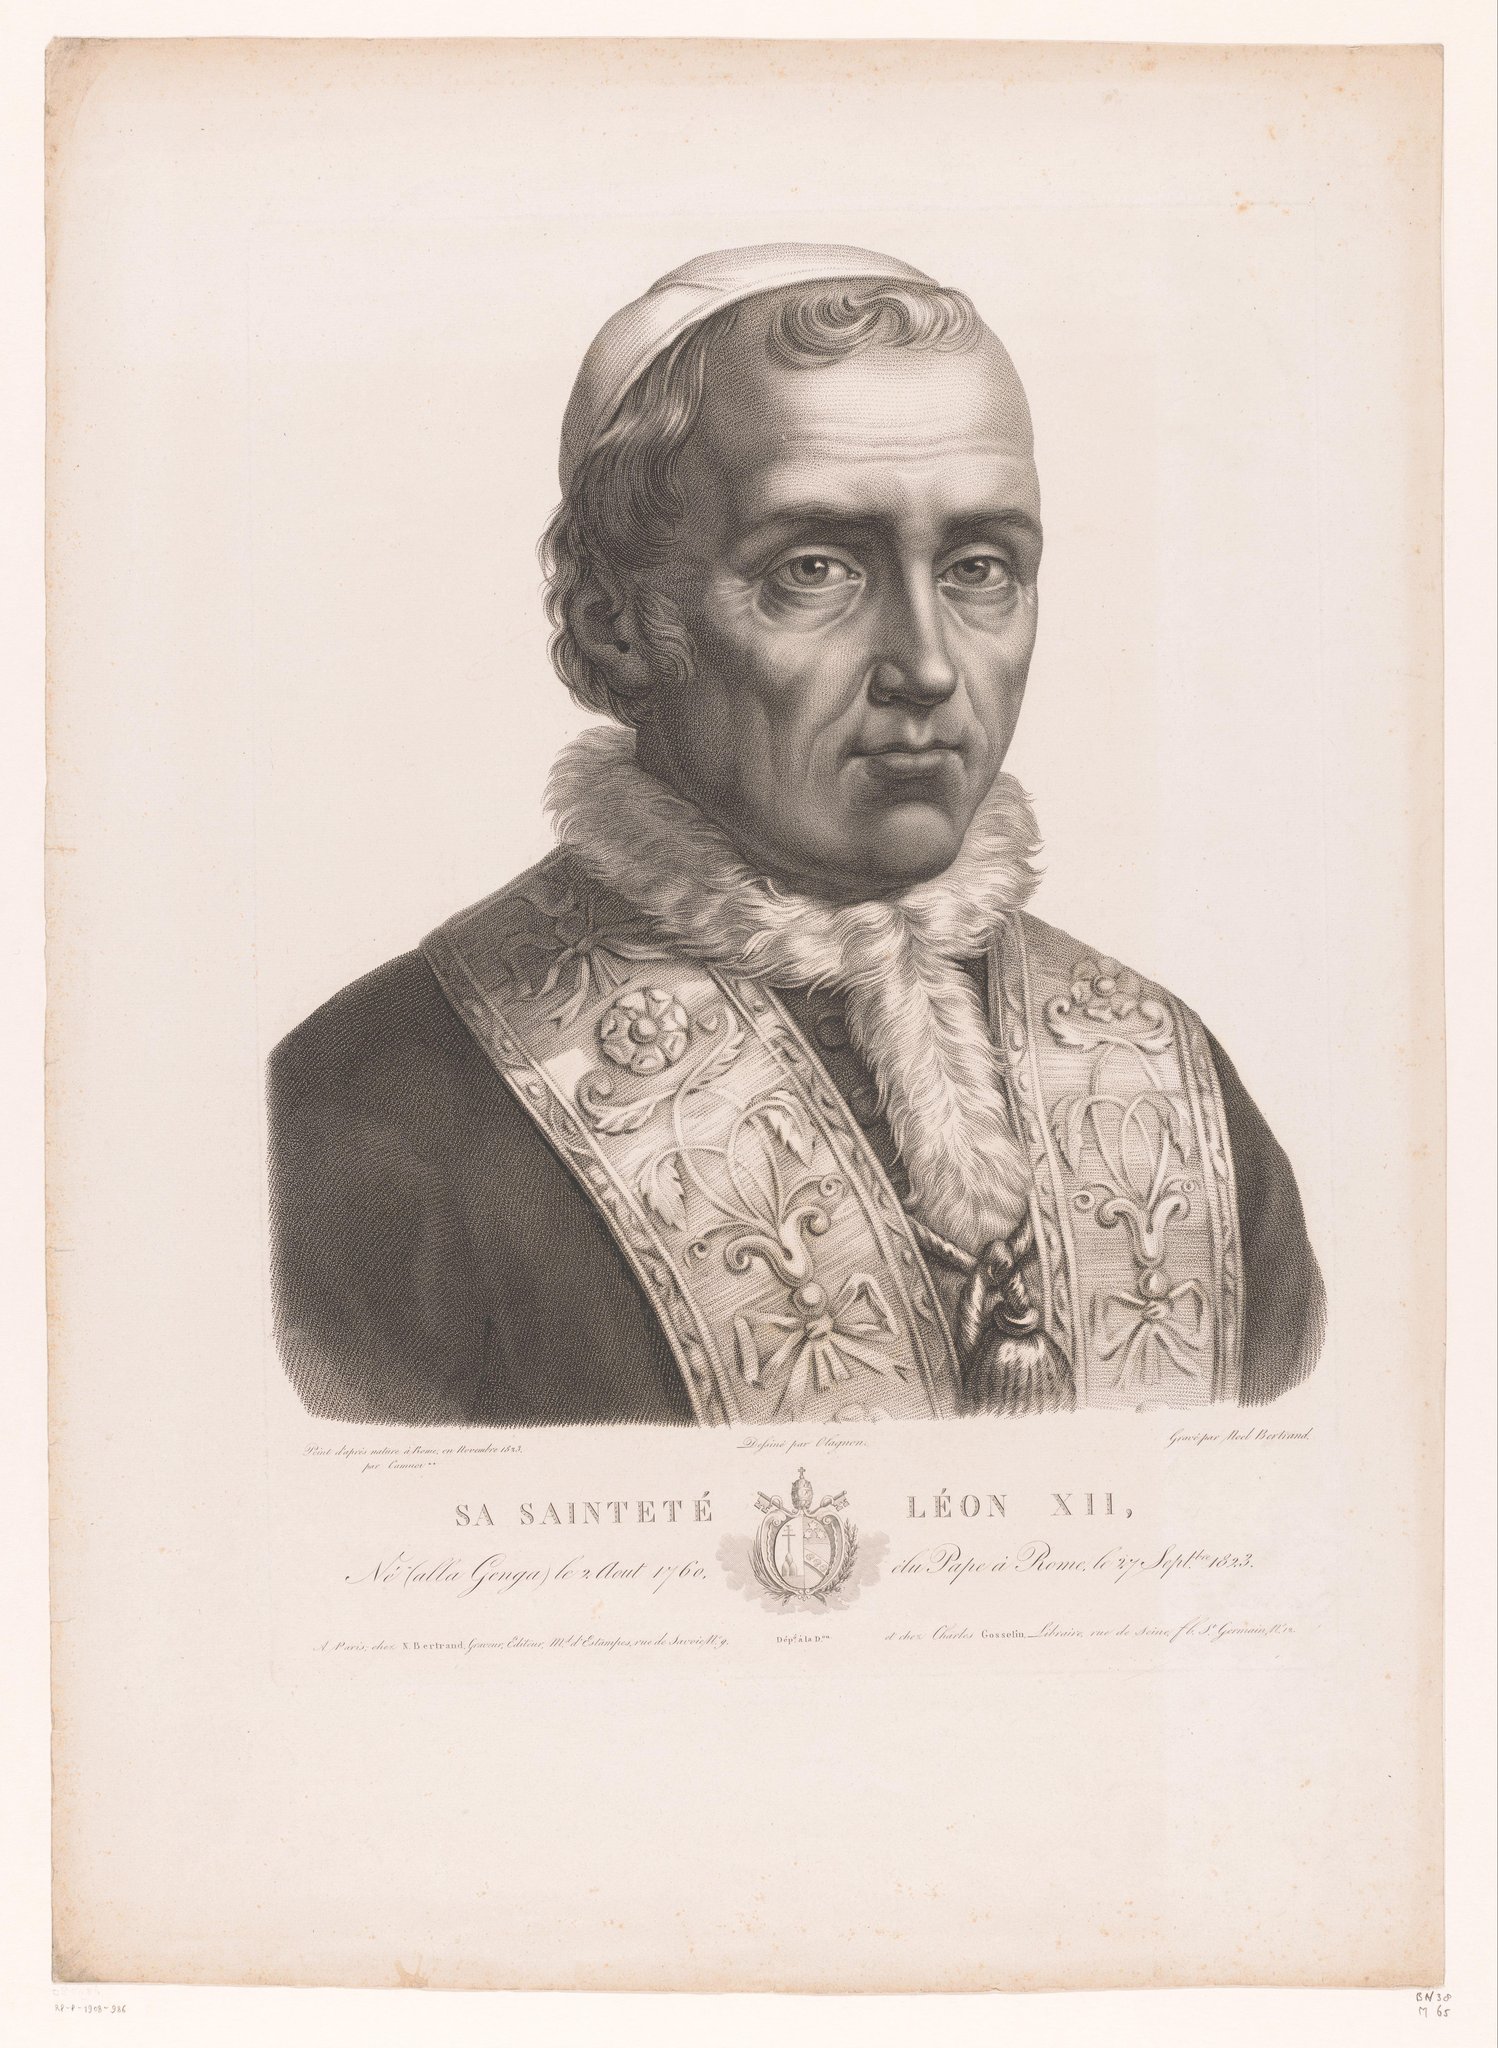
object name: print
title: Portret van paus Leo XII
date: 1823-1852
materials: paper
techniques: engraving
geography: paris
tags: rome, historical persons, pope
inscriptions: : ‘Dep. à la D.on’, collector's mark: Lugt 2228